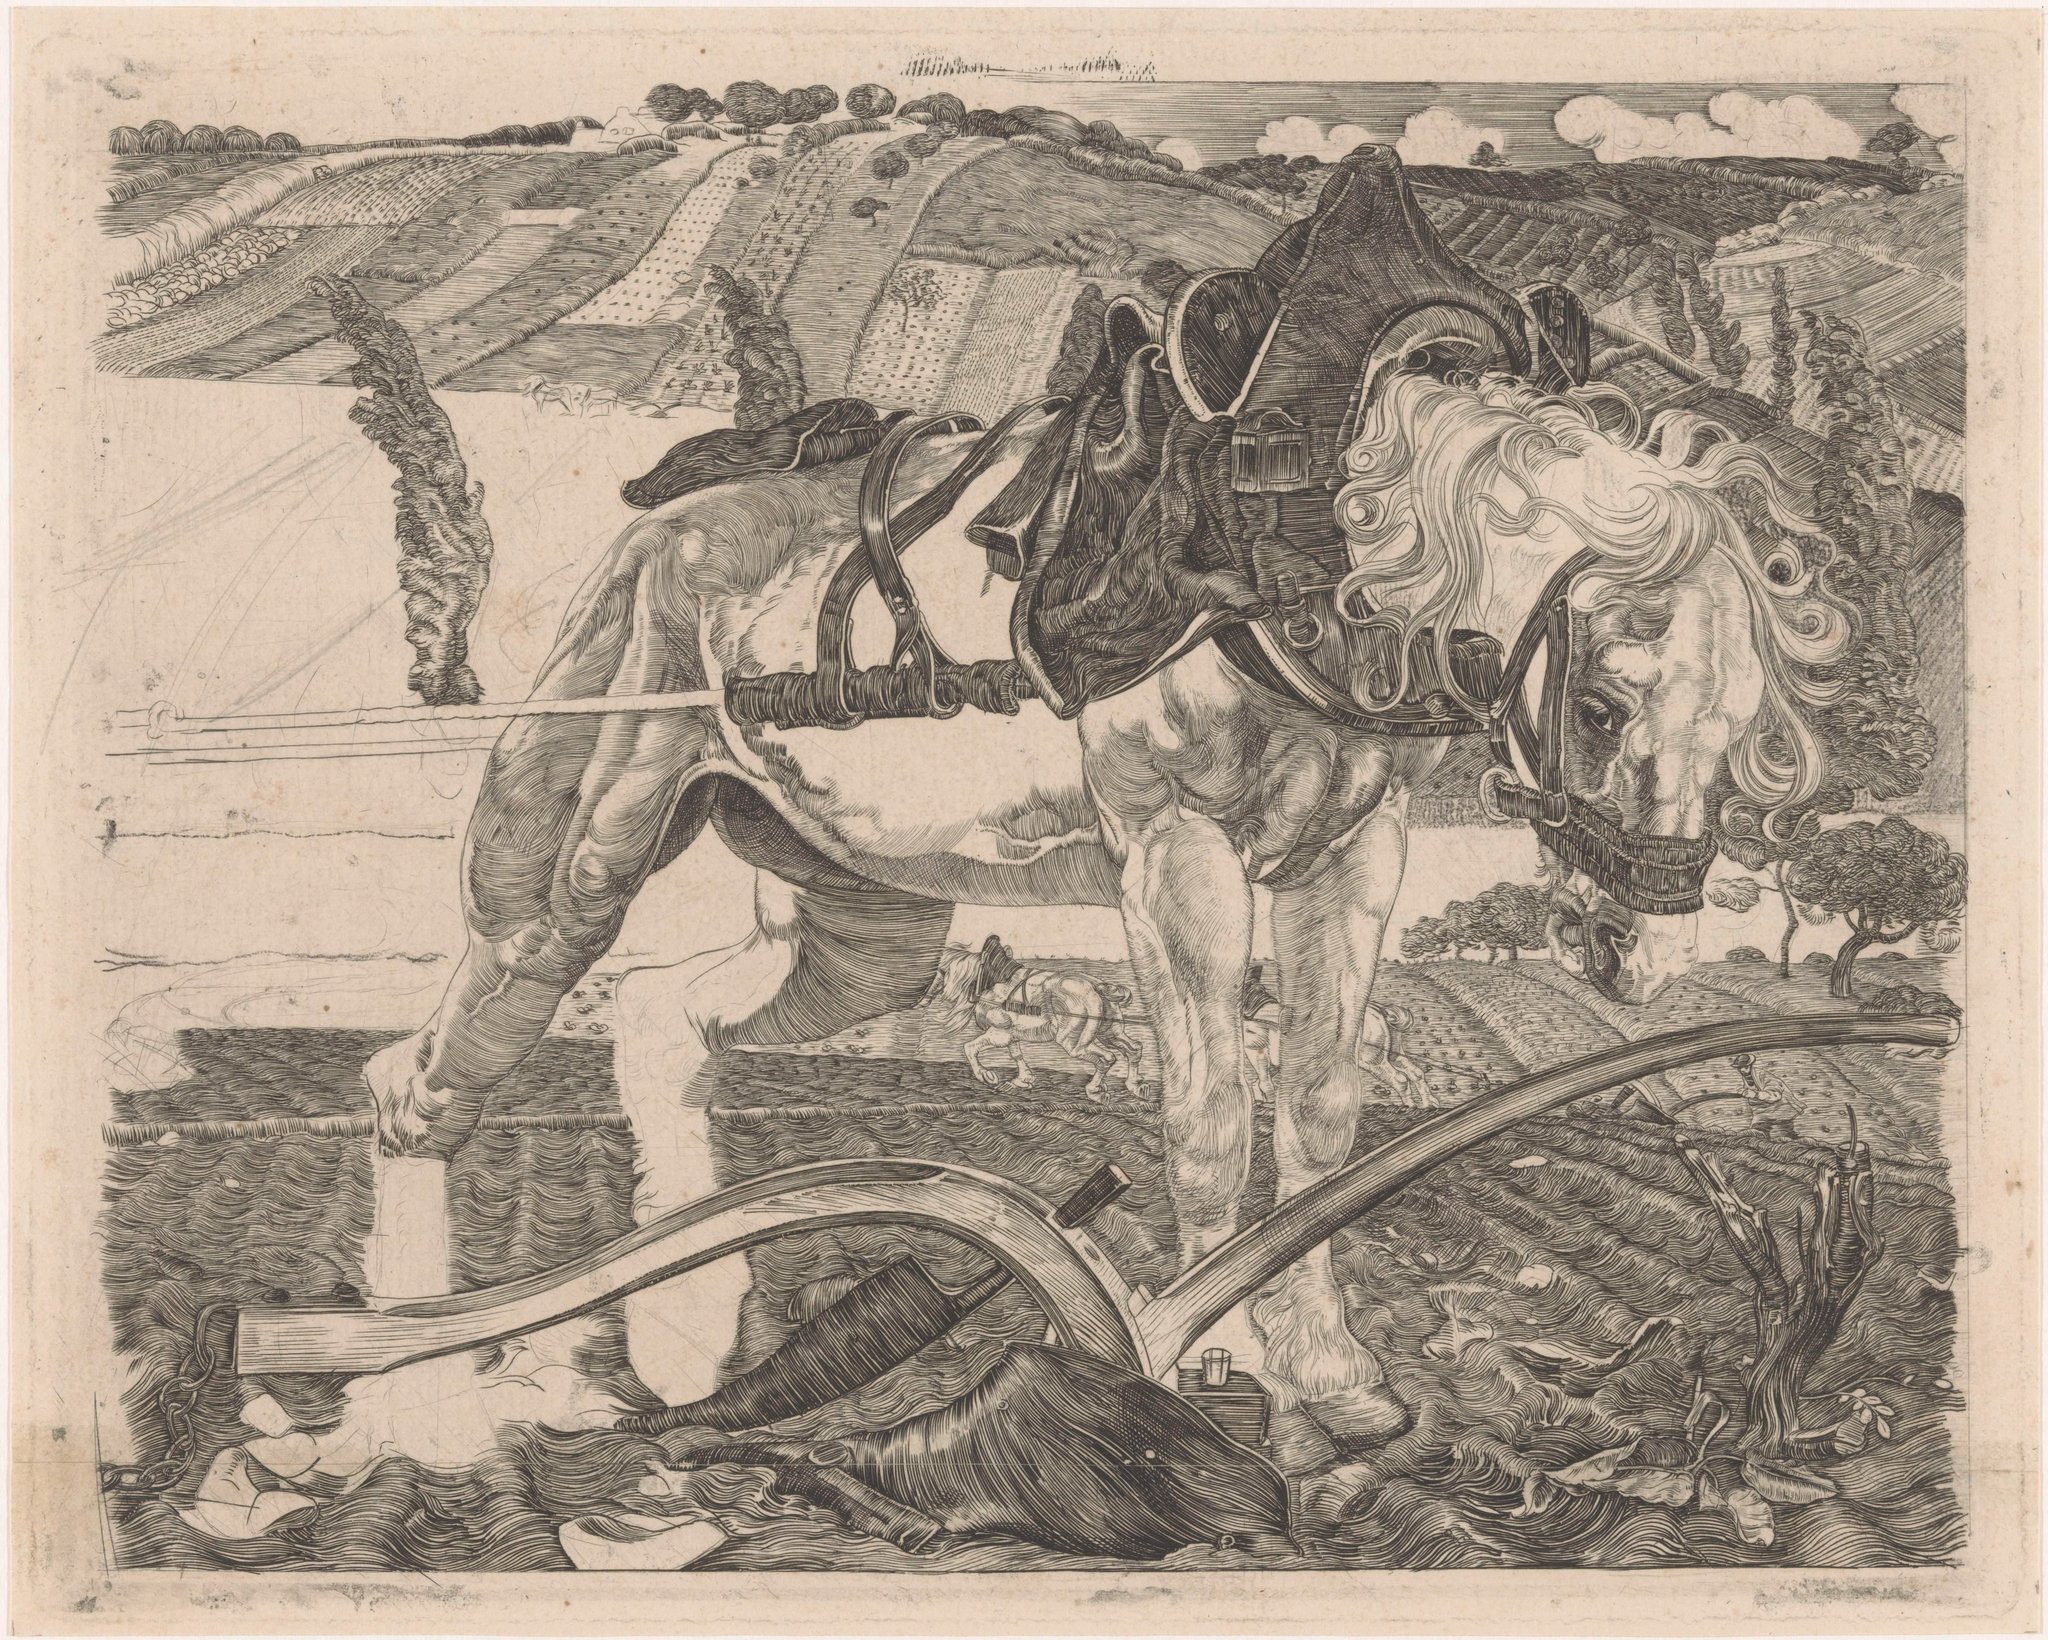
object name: print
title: L'Outillage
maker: pieter dupont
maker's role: draughtsman, print maker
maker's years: 1870-1911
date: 1899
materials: paper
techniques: engraving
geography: paris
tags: low hill country, horse, ploughing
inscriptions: collector's mark: Lugt 2233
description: Een paard trekt een ploeg over een akker nabij Parijs. Voor het paard ligt een ploeg. Op de achtergrond een heuvellandschap met een rivier.